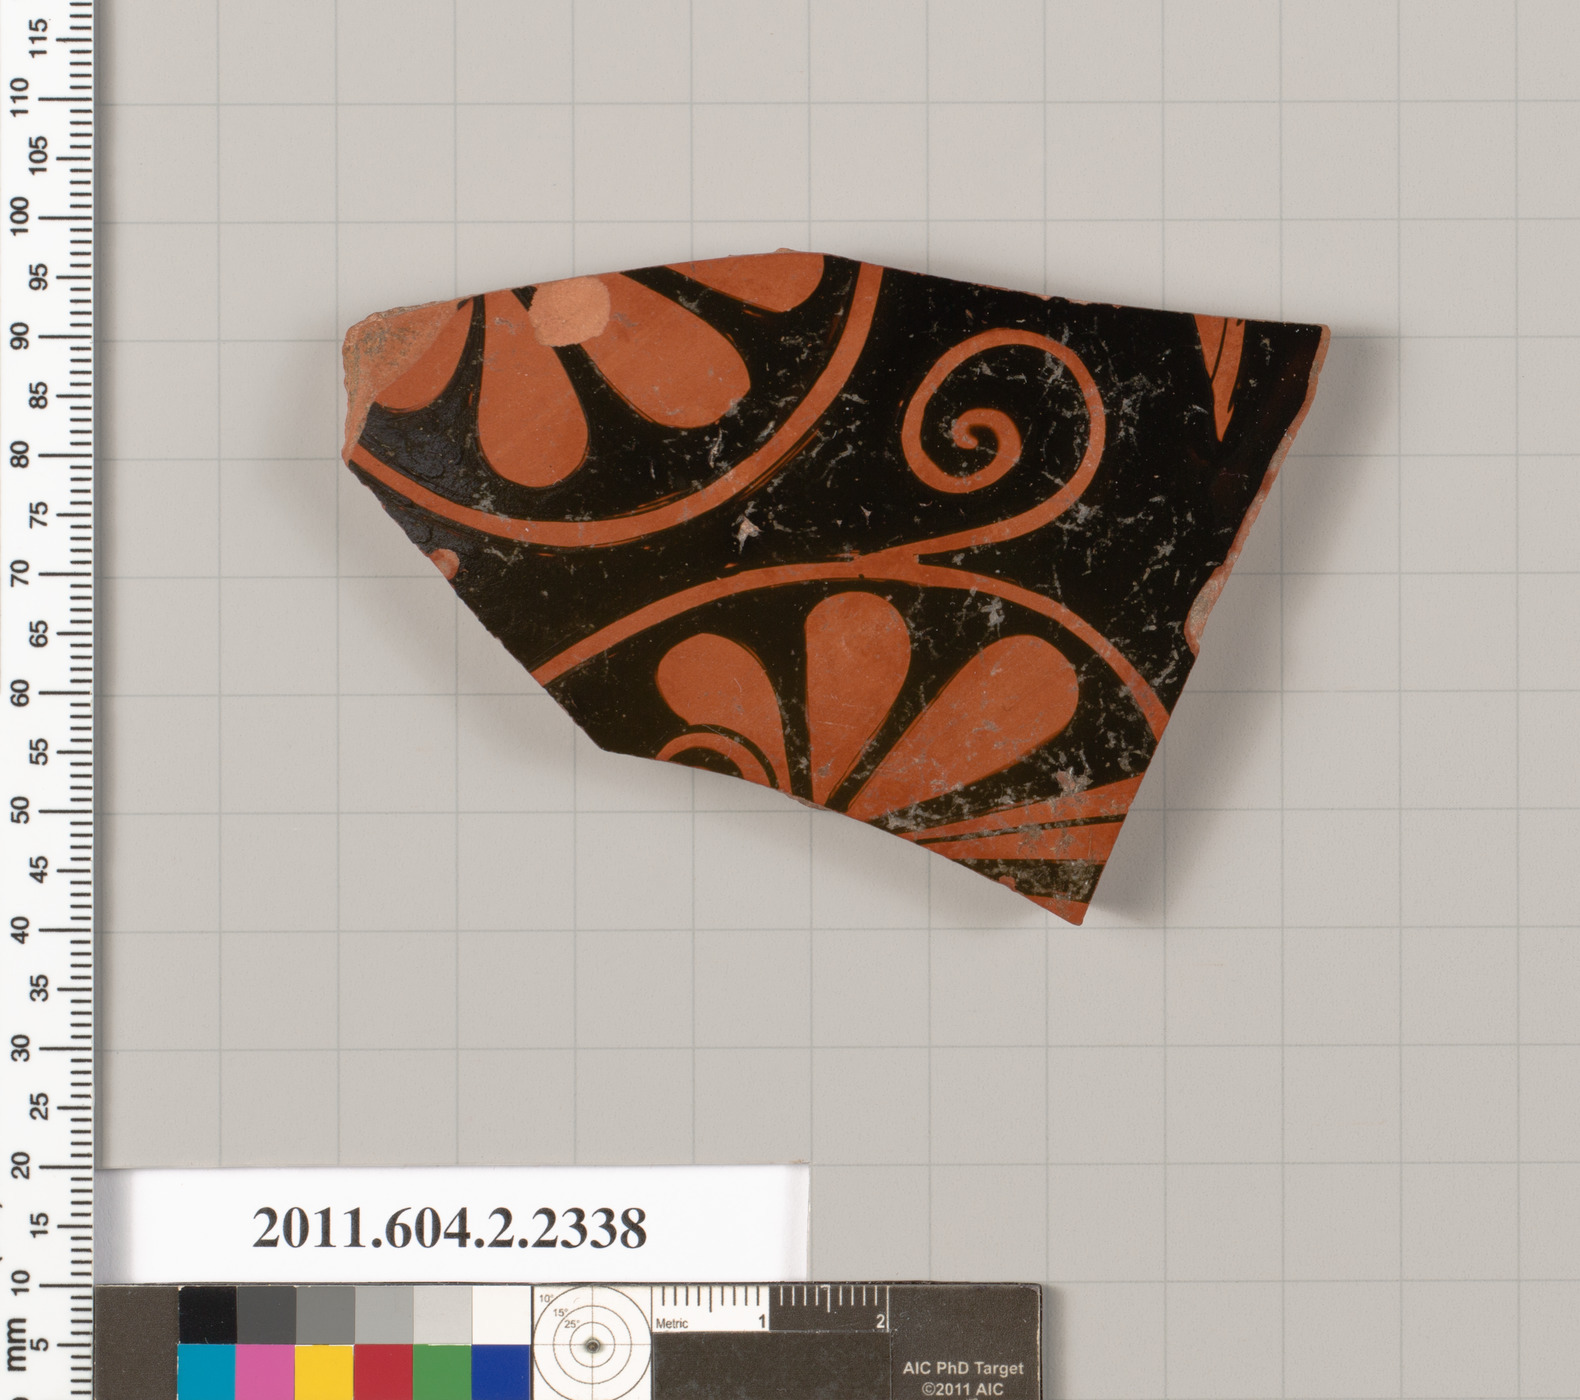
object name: stamnos fragment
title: Terracotta fragment of a stamnos (jar)?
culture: greek, attic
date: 520-500 BCE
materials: terracotta